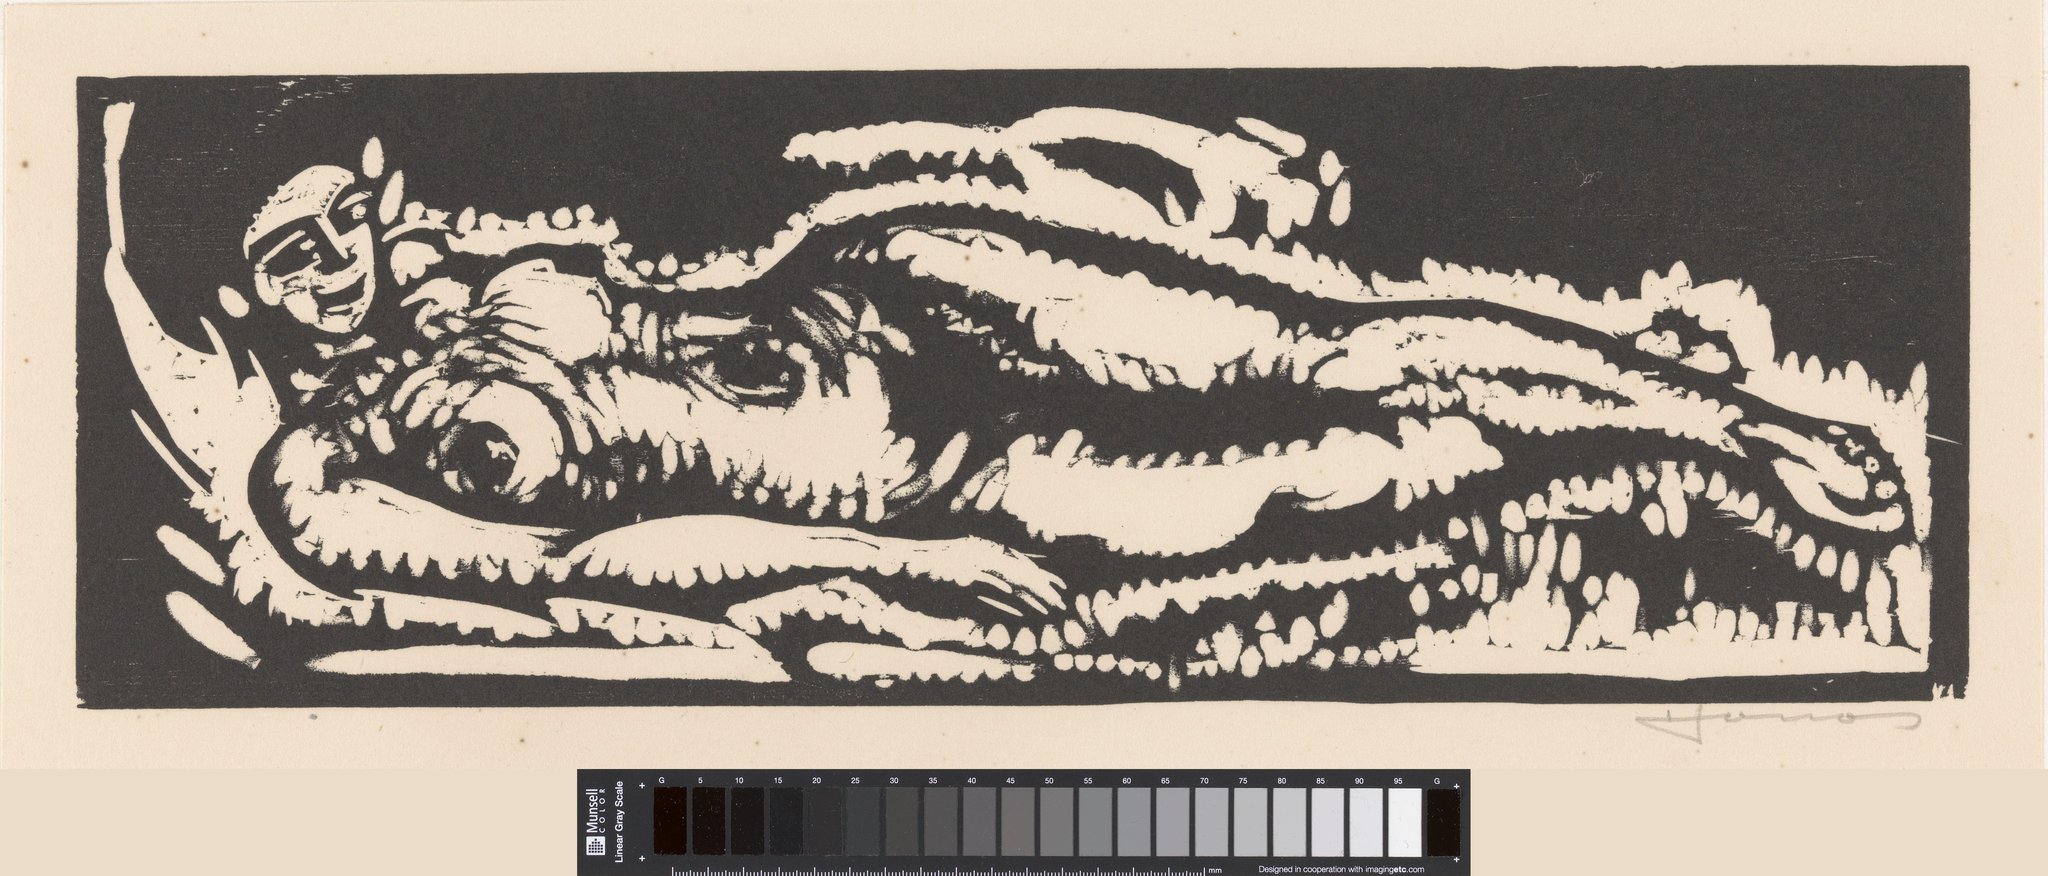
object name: print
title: Liggende, naakte vrouw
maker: henri jonas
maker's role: draughtsman, print maker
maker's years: 1878-1944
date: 1888-1931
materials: paper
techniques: woodcut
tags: woman (showing herself) undressed, quasi-nude, lying figure - aa - female human figure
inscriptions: collector's mark: Lugt 2228